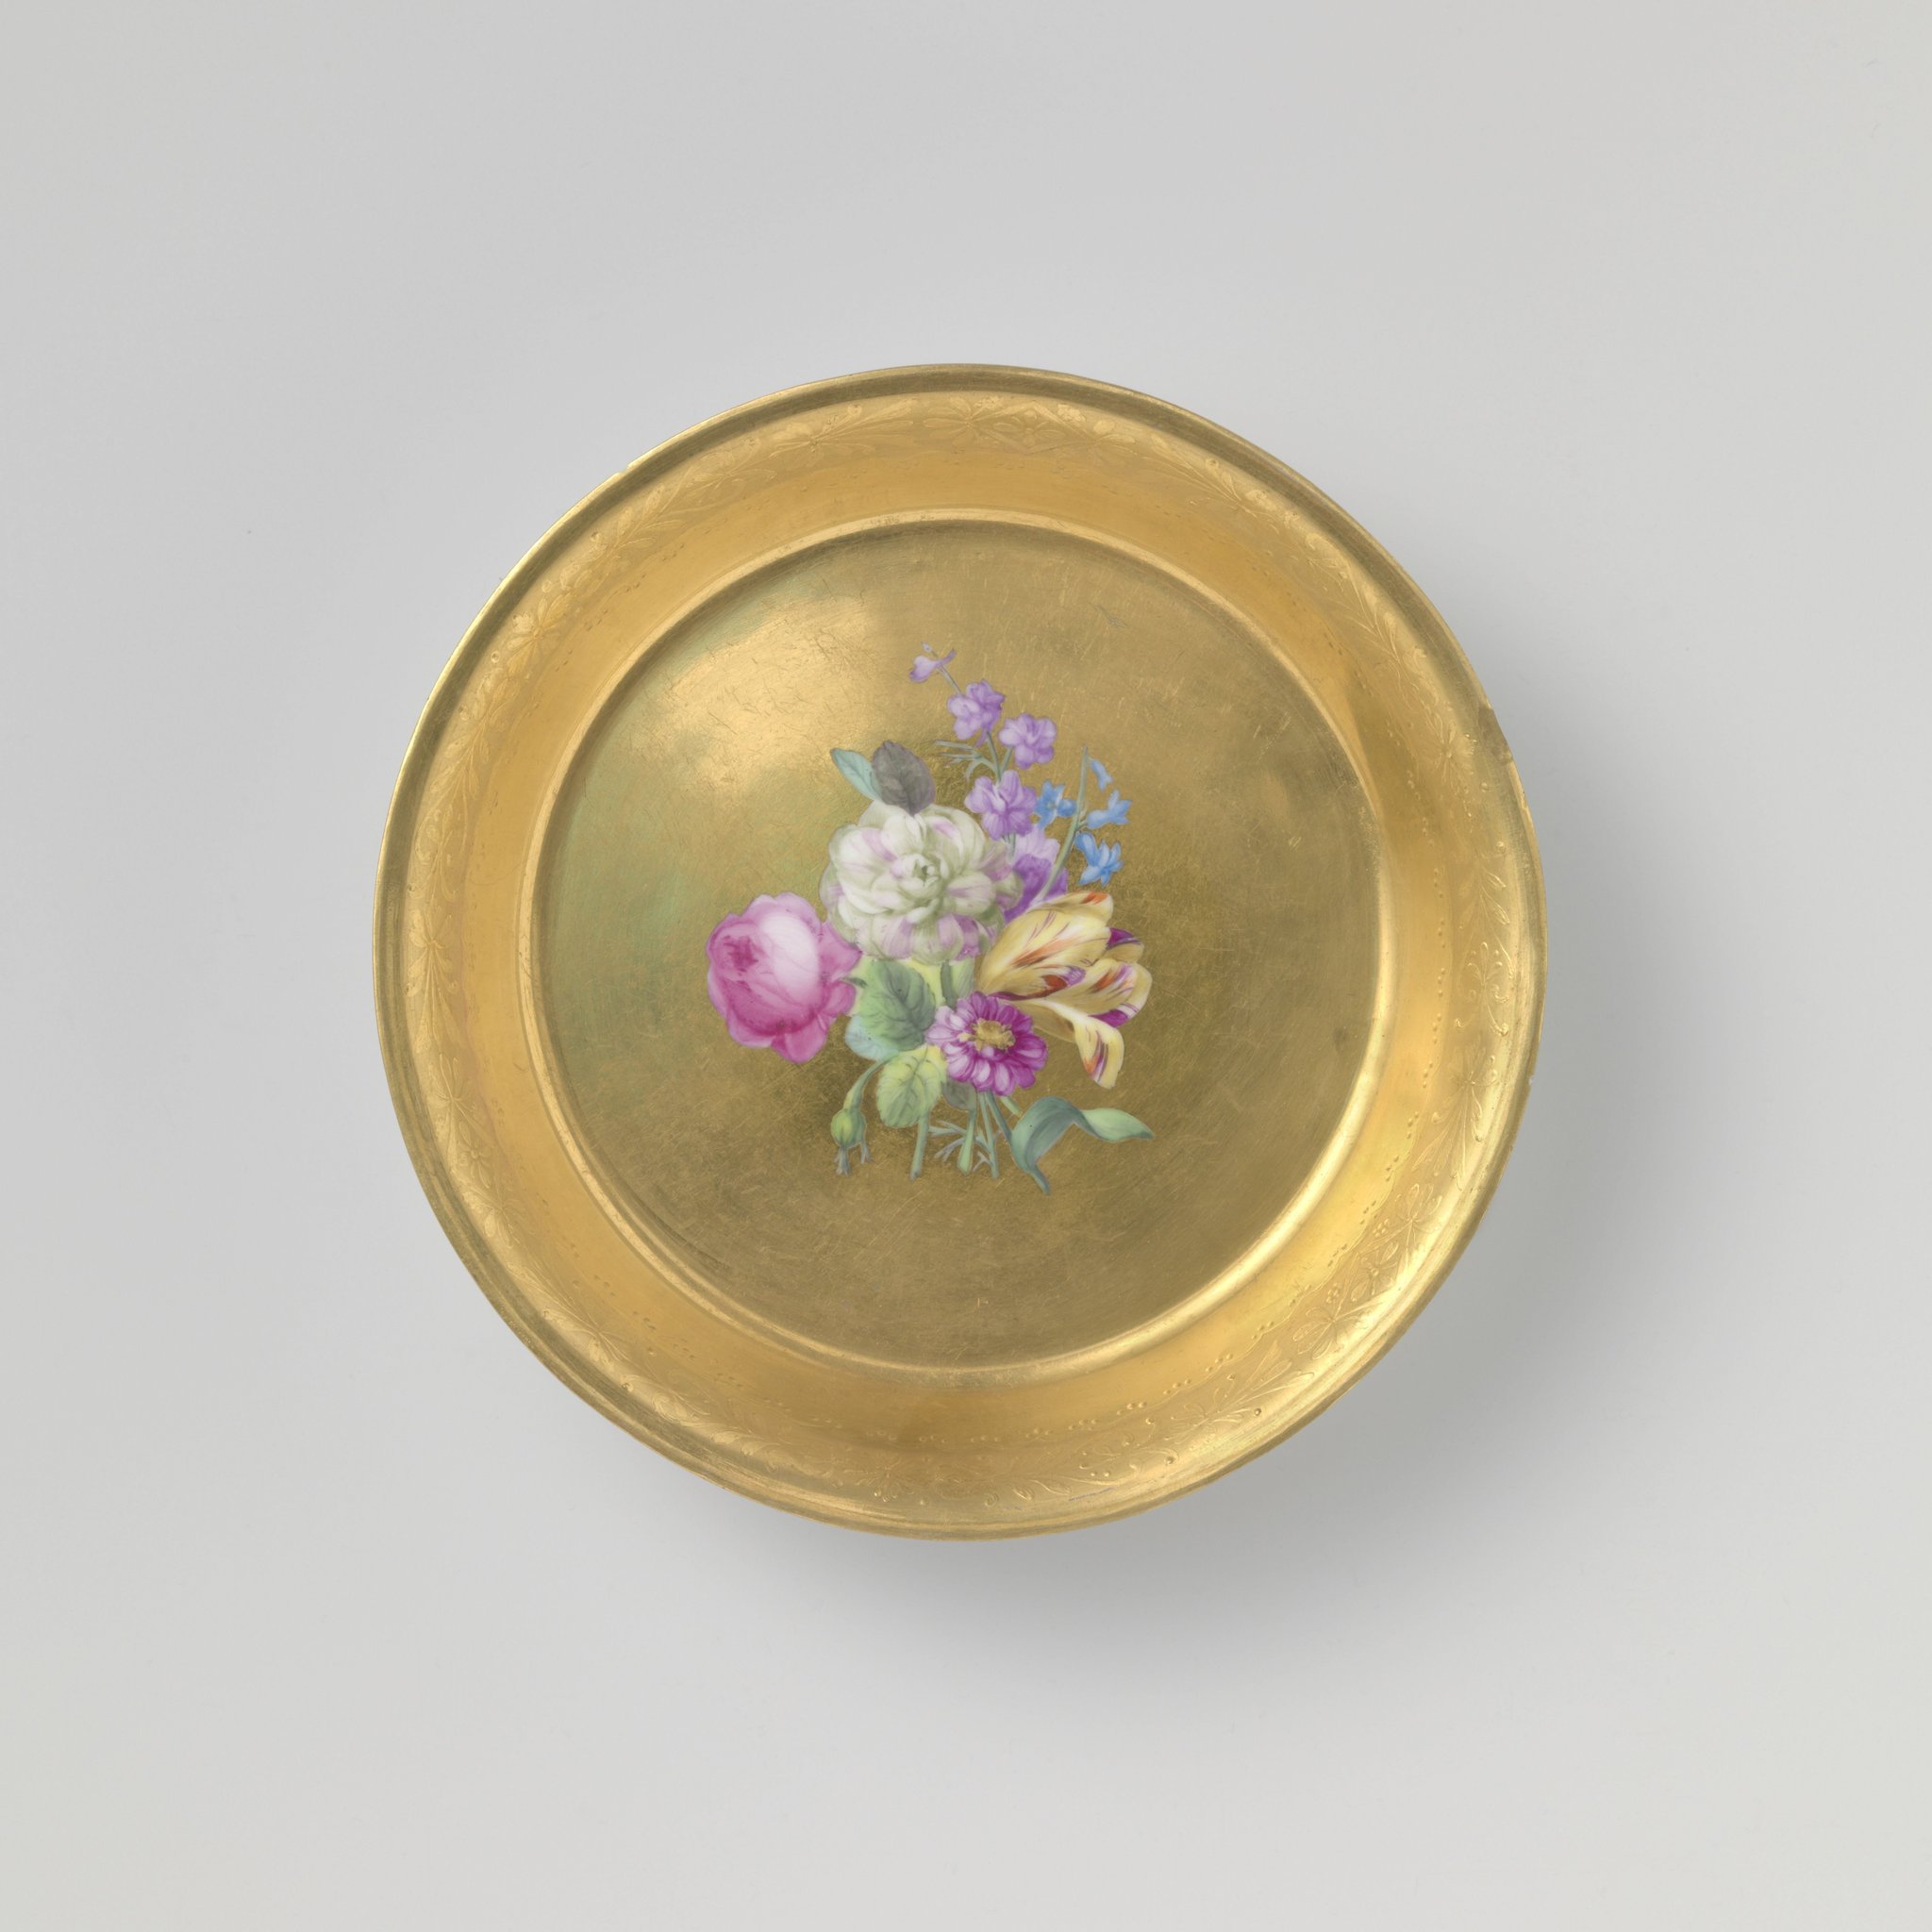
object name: platter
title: Saucer with a bouquet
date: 1798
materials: glaze, gold, paint, porcelain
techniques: firing, forming, gilding, turning, vitrification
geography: vienna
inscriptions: mark: ‘schild/ XI?/ 98’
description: Schotel van porselein met een rechte wand, beschilderd op het glazuur in blauw, rood, roze, groen, geel, paars, zwart en goud. De binnenzijde van de schotel is bedekt met goud, met daarin uitgespaard een boeket van verschillende bloemen. De binnenwand met een band van bloemranken in goudreliëf. Gemerkt op de onderzijde met het schild, XI[?] en tweemaal het jaarnummer 98.